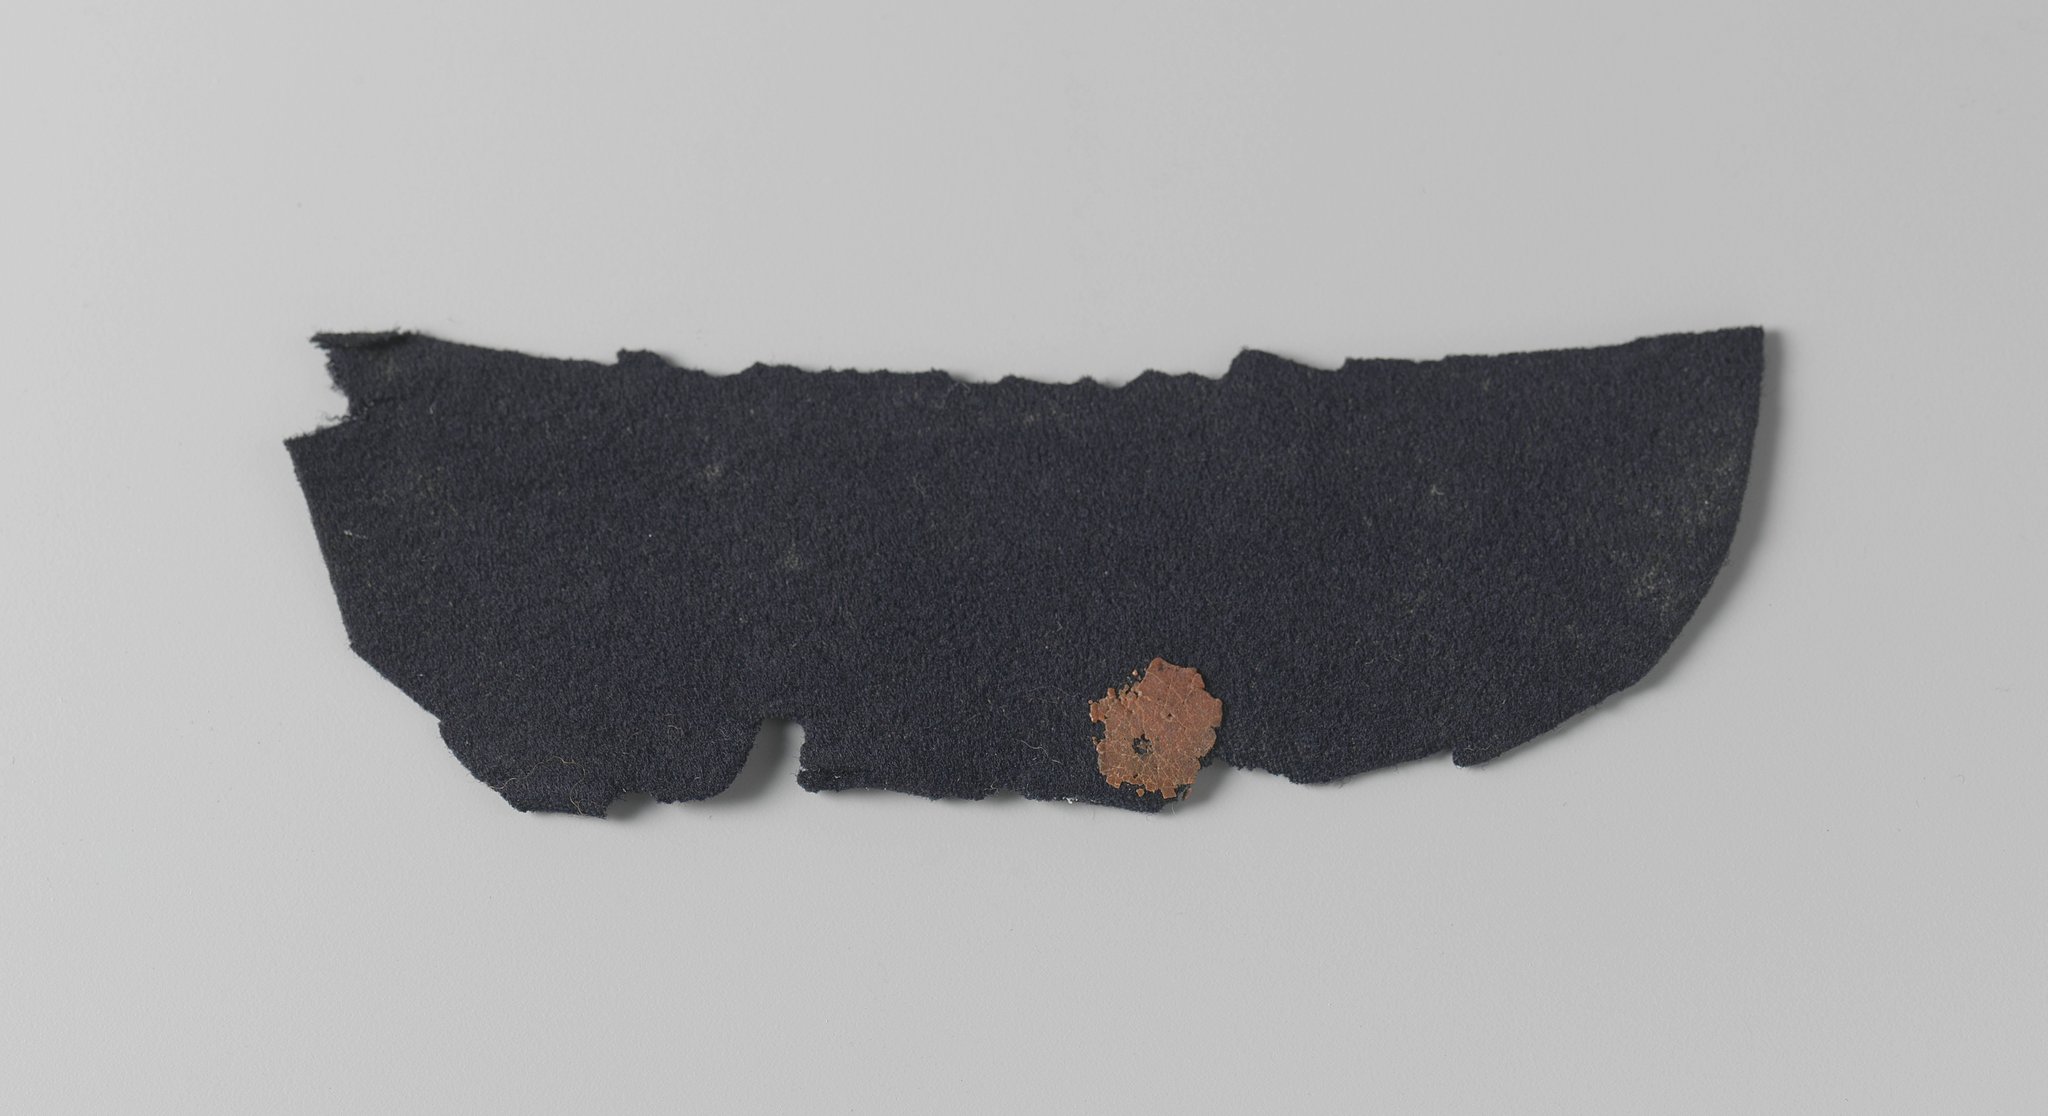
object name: fragment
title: Stuk laken van de uniformrok van Van Speyk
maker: Anonymous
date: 1831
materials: textile, linen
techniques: pressing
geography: netherlands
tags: amsterdam, antwerp, jan van speyk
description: Een langwerpig stuk donkerblauwe stof in een beschreven stukje papier (NG-321-b) gevouwen. Op de stof is aan één zijde een plekje zegellak aanwezig. Van de lak op de hoeken van het briefje zijn alleen nog resten over.